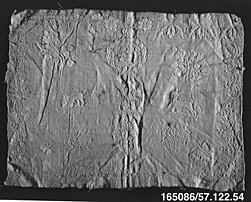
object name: sampler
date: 1801-1900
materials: cotton